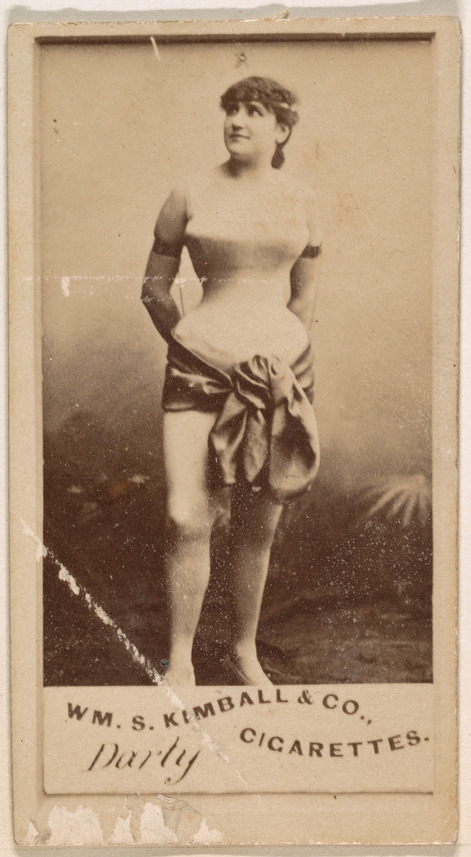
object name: photograph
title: Miss Darly, from the Actresses series (N203) issued by Wm. S. Kimball & Co.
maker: william s. kimball & company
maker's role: publisher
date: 1889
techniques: color lithograph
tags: portraits,women,actresses